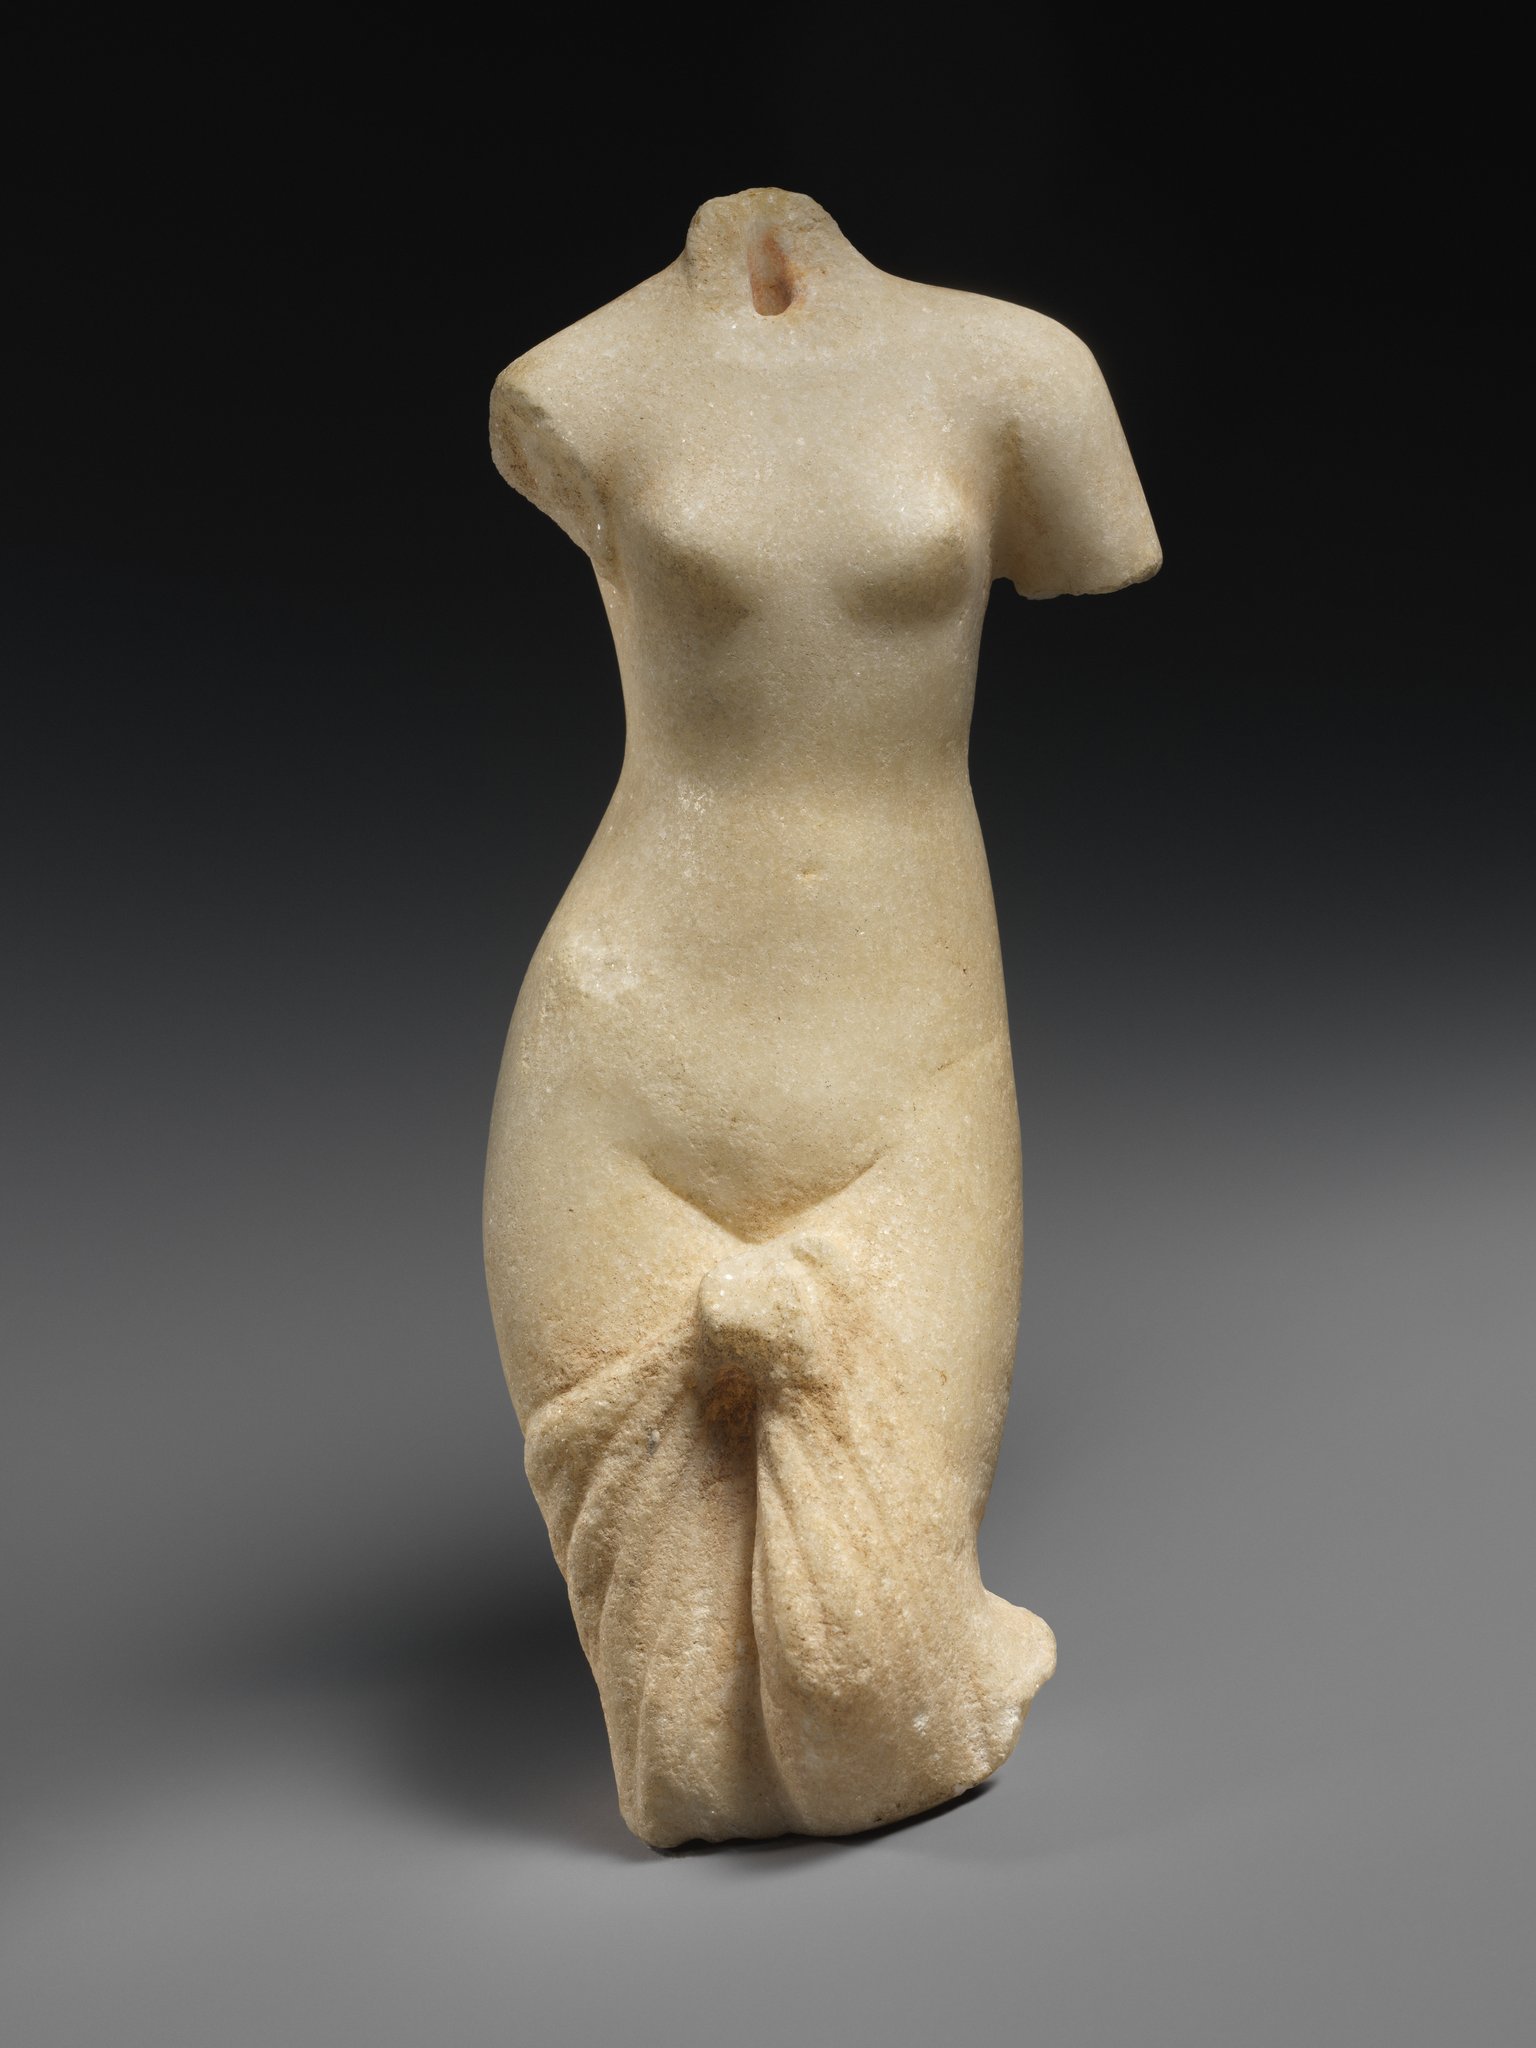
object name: statuette of aphrodite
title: Marble Aphrodite statuette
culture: greek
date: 100-1 BCE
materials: marble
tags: female nudes,aphrodite